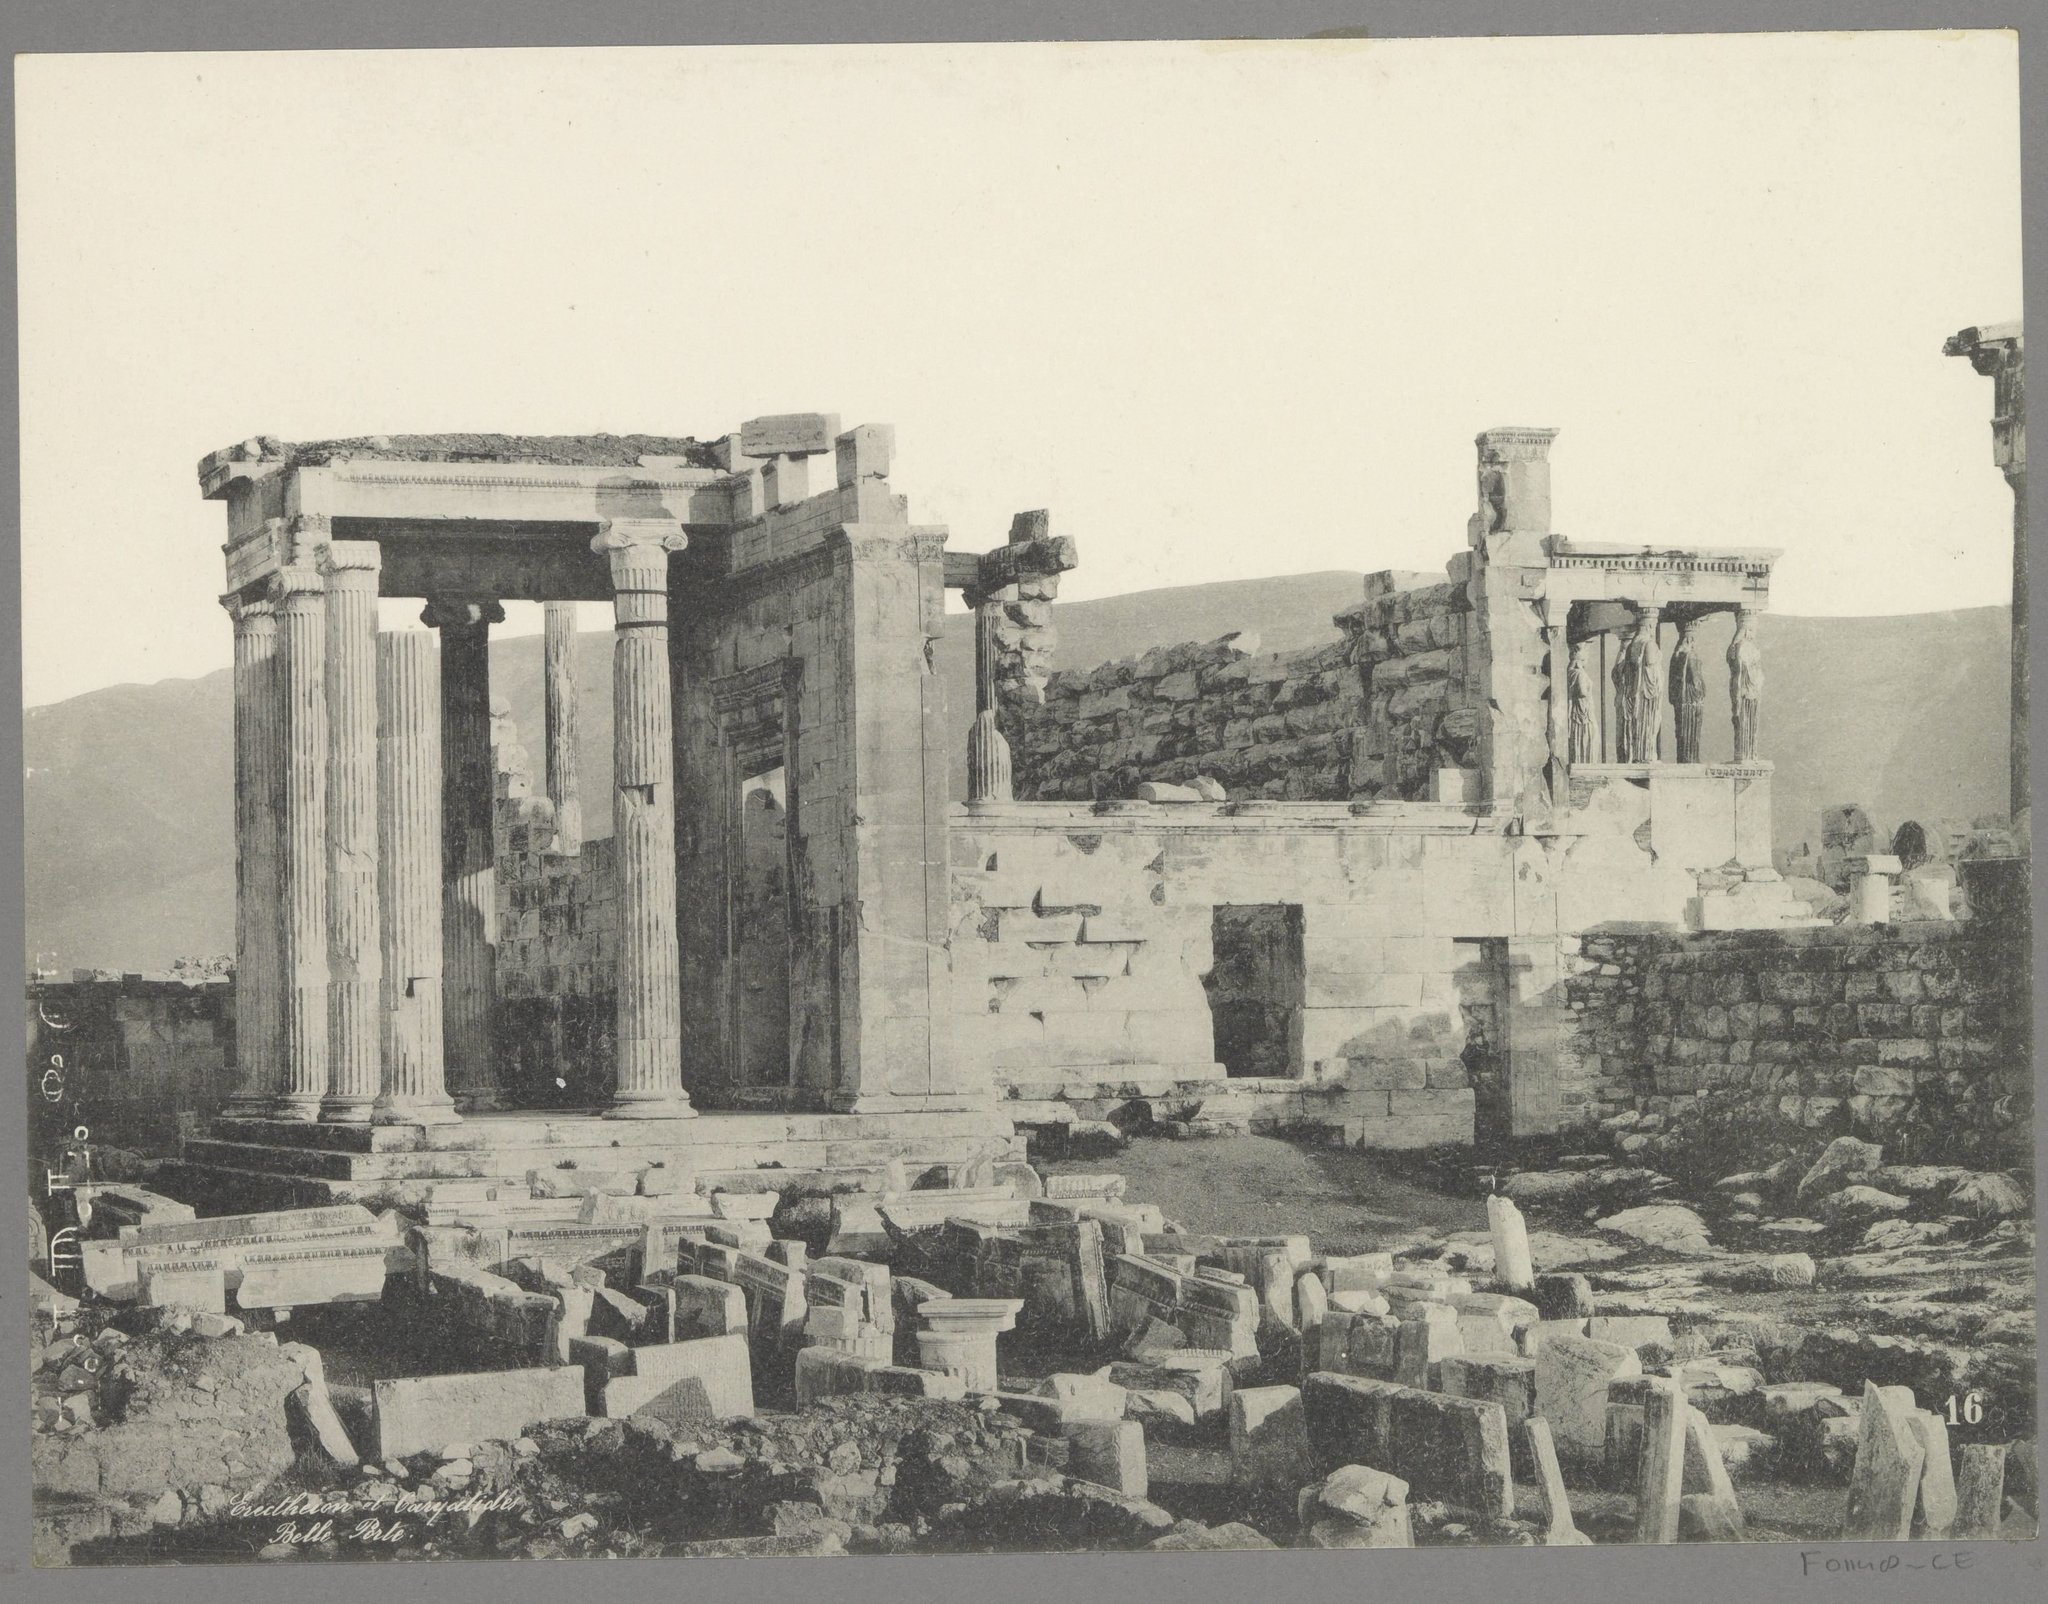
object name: photograph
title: Erectheion et Caryatides, Belle Porte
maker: Anonymous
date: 1895-1905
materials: paper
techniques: photograph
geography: acropolis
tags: caryatids ~ architecture, temple, shrine ~ greek religion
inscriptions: number: ‘16’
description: Onderdeel van Reisalbum met foto's van bezienswaardigheden in Griekenland en Egypte.